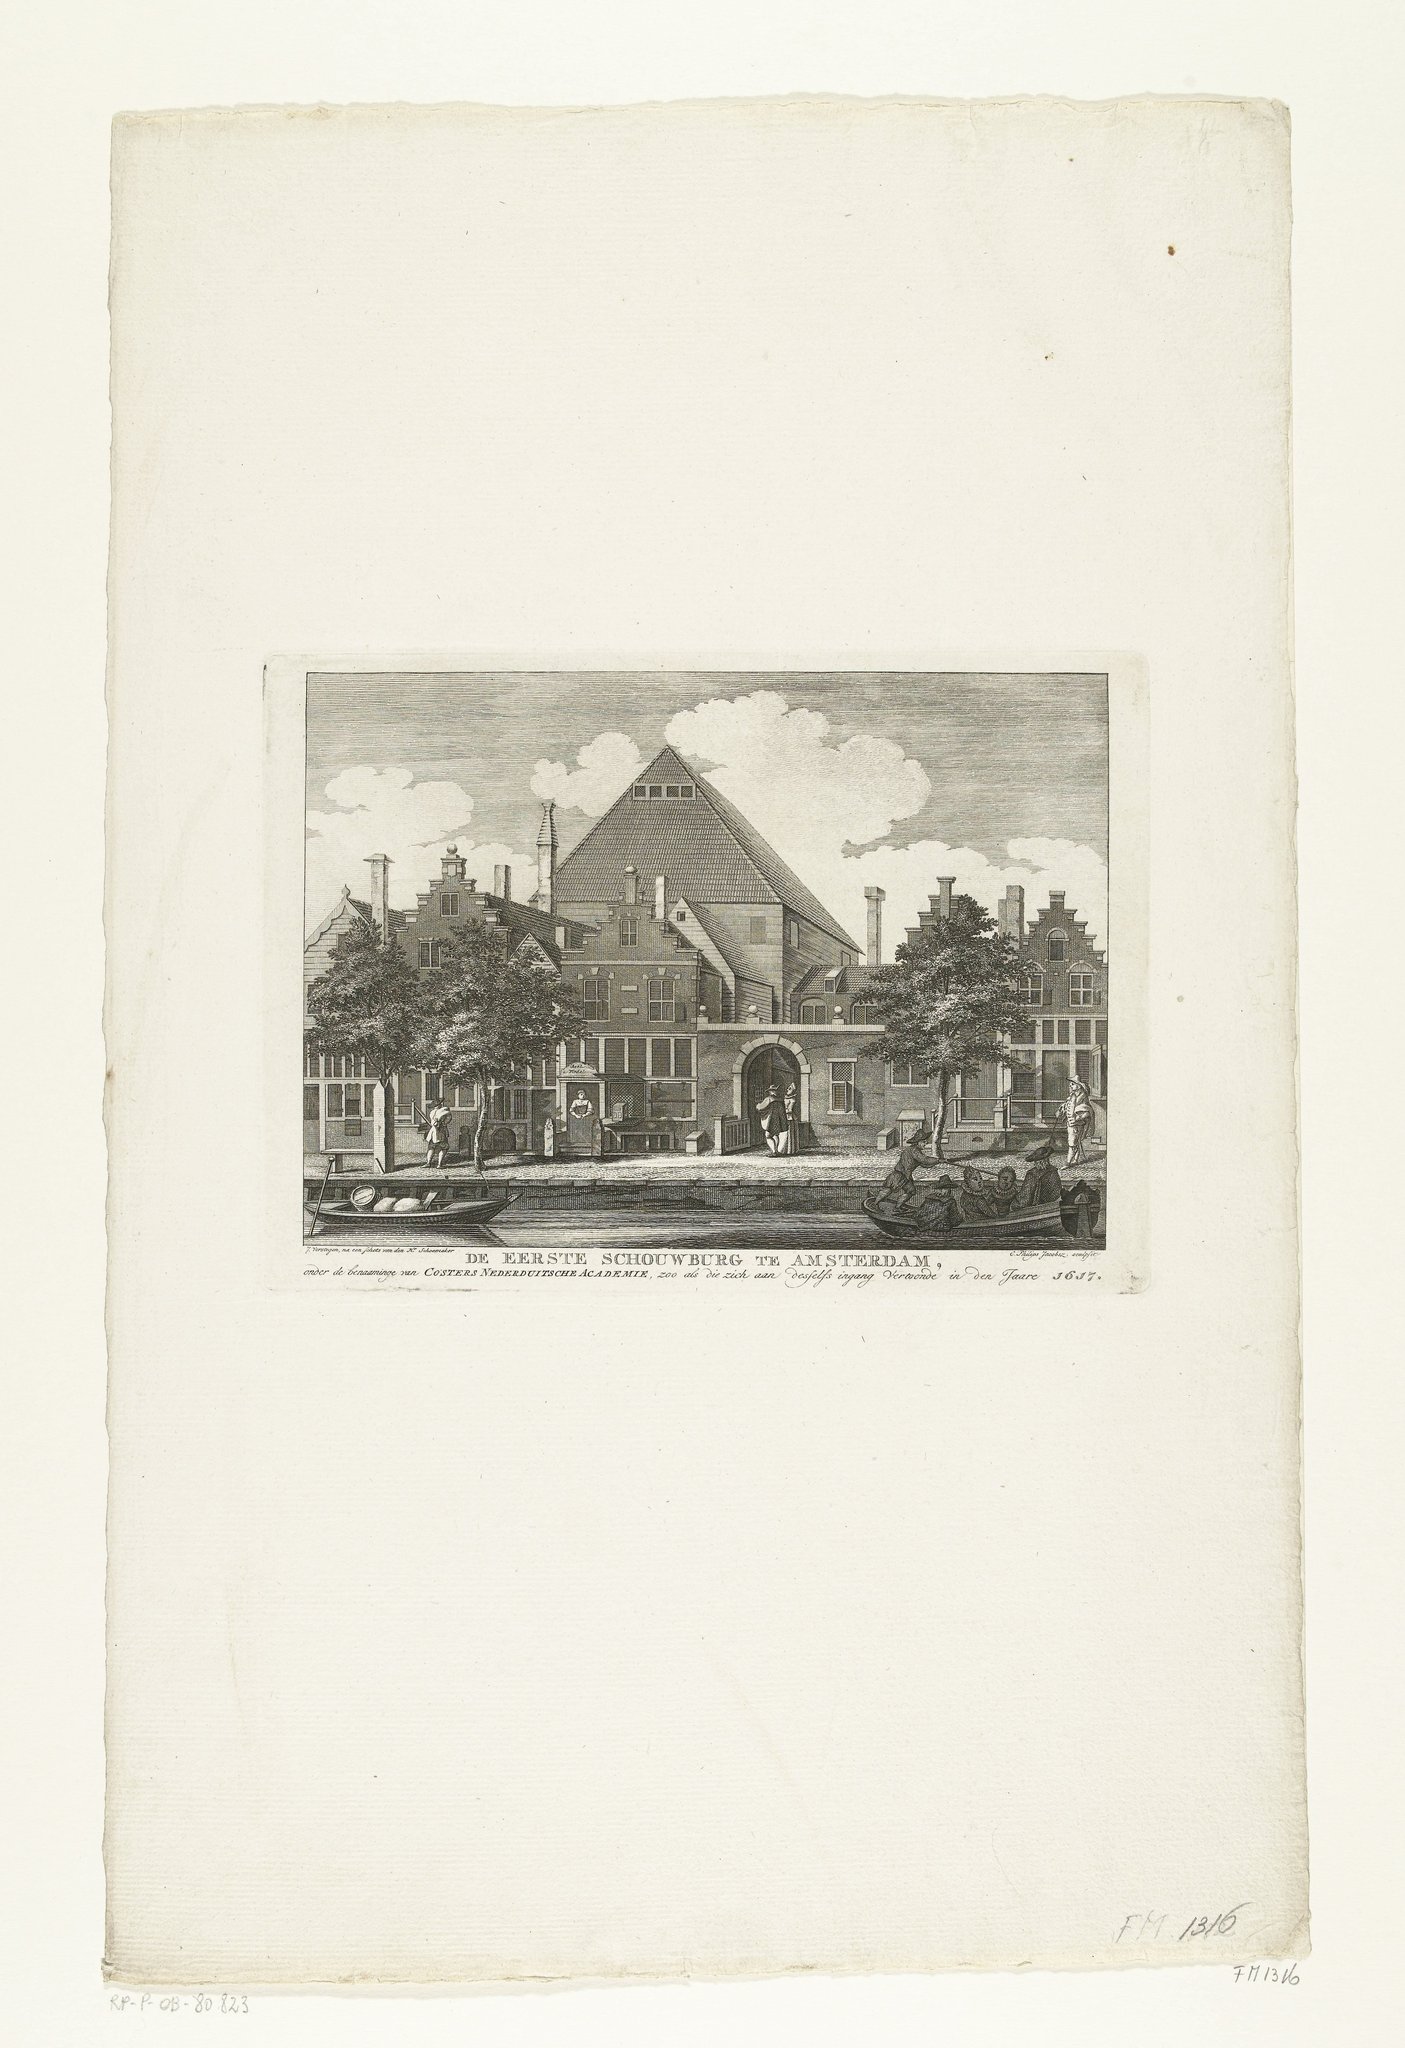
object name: print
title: De eerste schouwburg te Amsterdam, onder de benaaminge van Costers Nederduitsche Academie, zoo als die zich aan desselfs ingang vertoonde in den jaare 1617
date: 1752-1789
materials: paper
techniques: engraving, etching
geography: amsterdam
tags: samuel coster, theatre (building), canals, waters (in city) (+ city(-scape) with figures, staffage), street (+ city(-scape) with figures, staffage), book-shop, bookseller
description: Gezicht op de Nederduitse Academie (Eerste Nederduytsche Academie) van Samuel Coster aan de Keizersgracht te Amsterdam, gelegen ter hoogte van het huidige nummer 384. Zoals het eruit zou hebben gezien in het jaar van oprichting 1617. Links van de toegangspoort een boekwinkel. Op straat en in het bootje rechtsvoor enkele figuren.